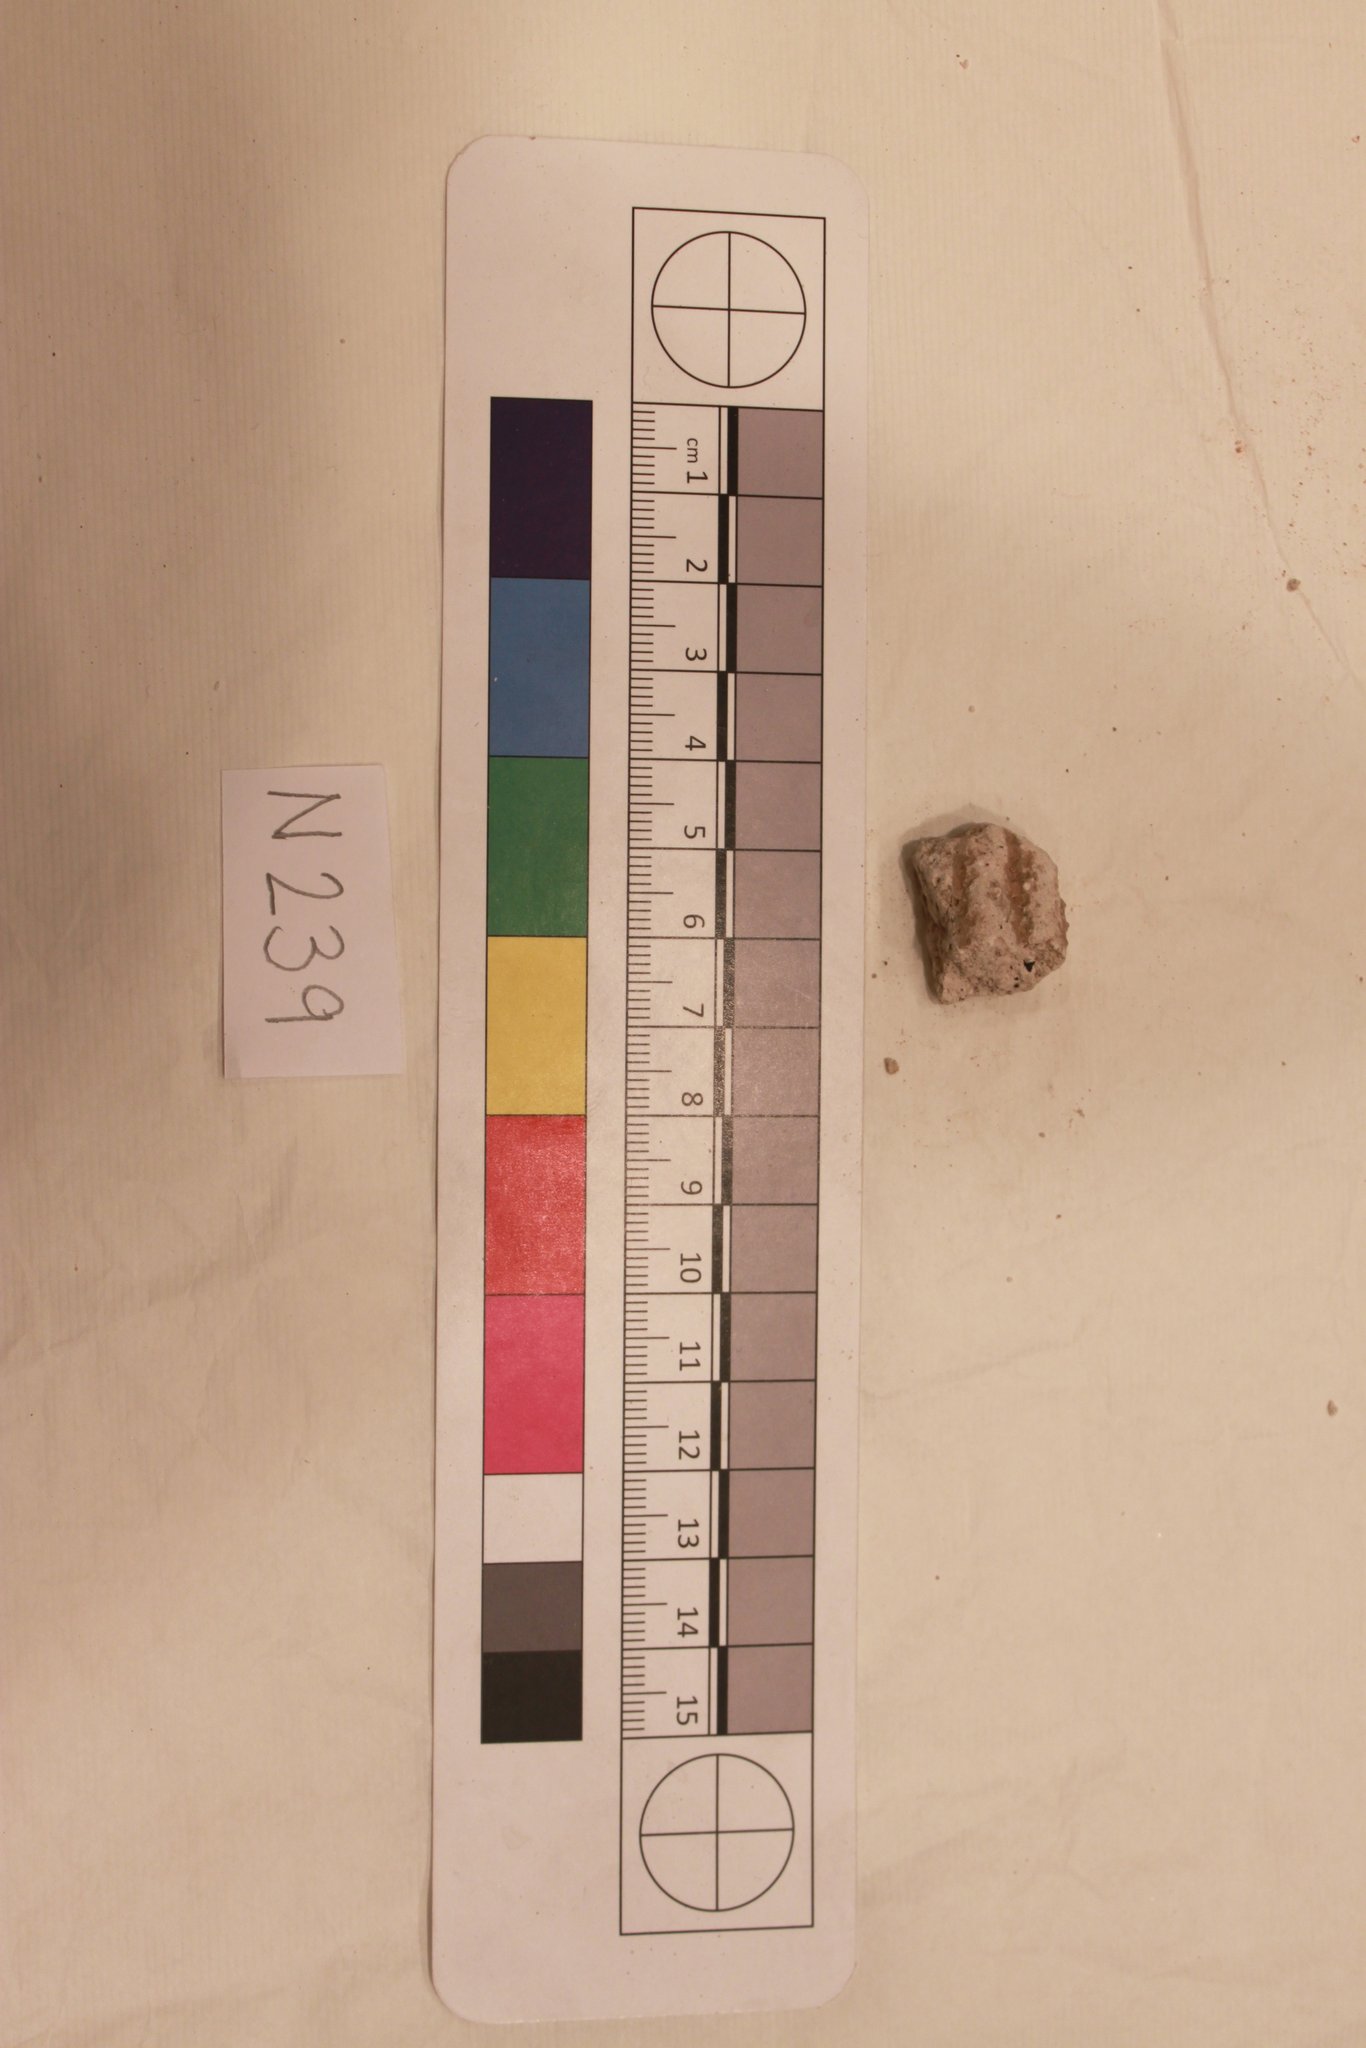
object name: fragment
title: Stucco Fragment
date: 701-1200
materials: plaster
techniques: carving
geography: iran